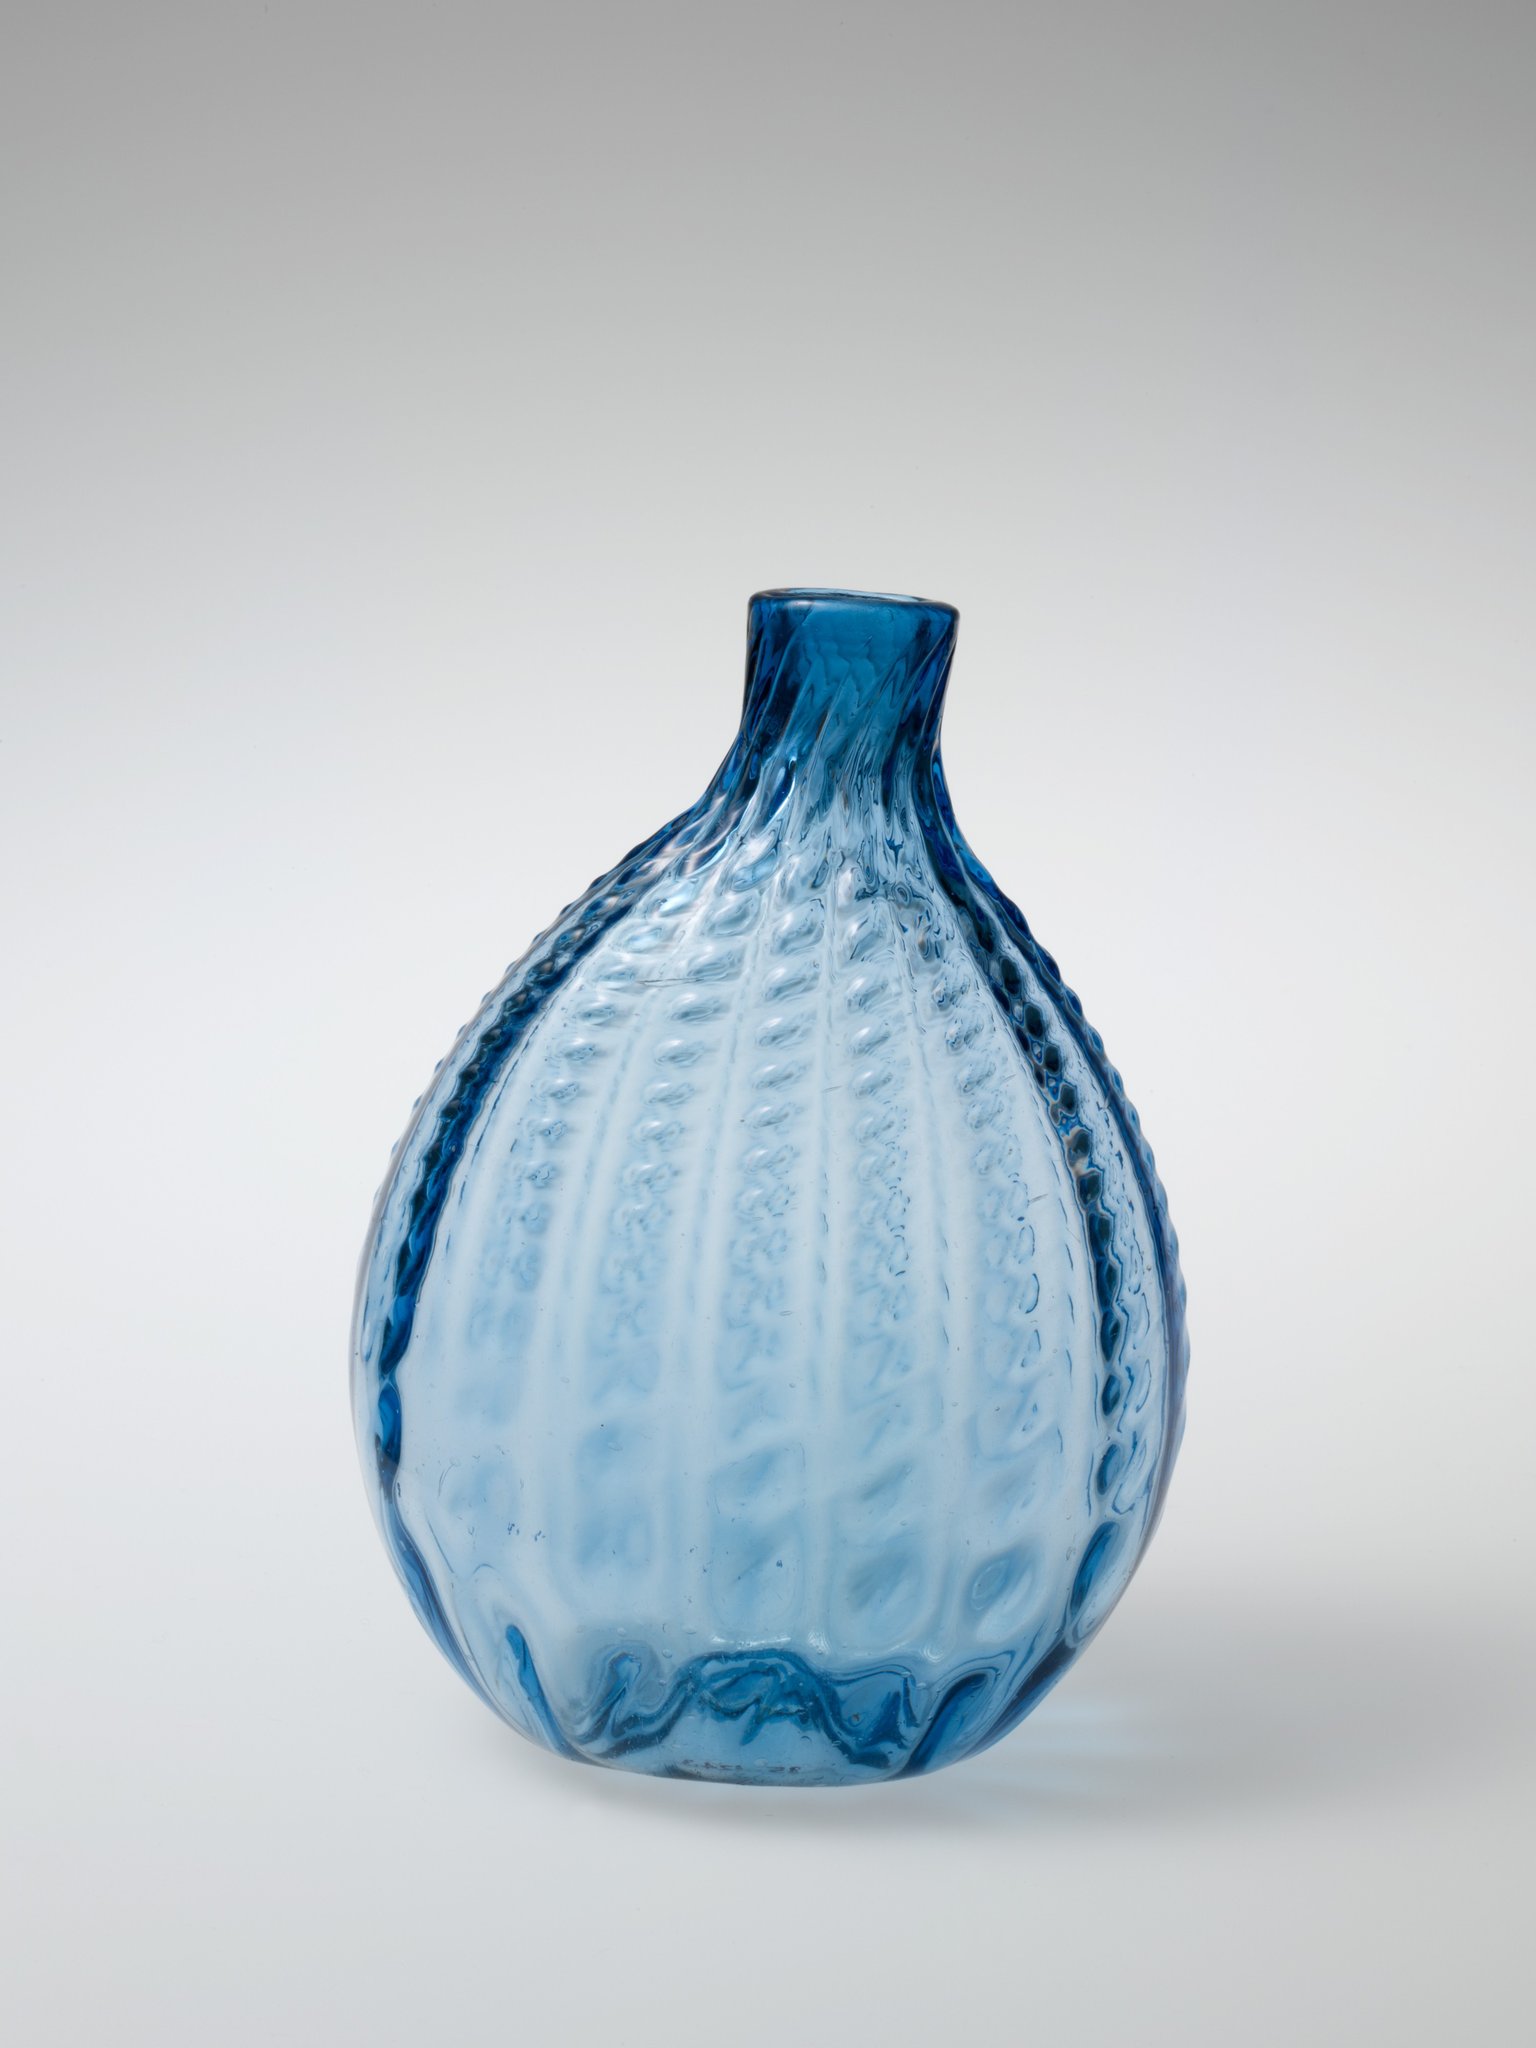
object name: pocket bottle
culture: american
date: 1815-1840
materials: glass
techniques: glassblowing, molding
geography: united states